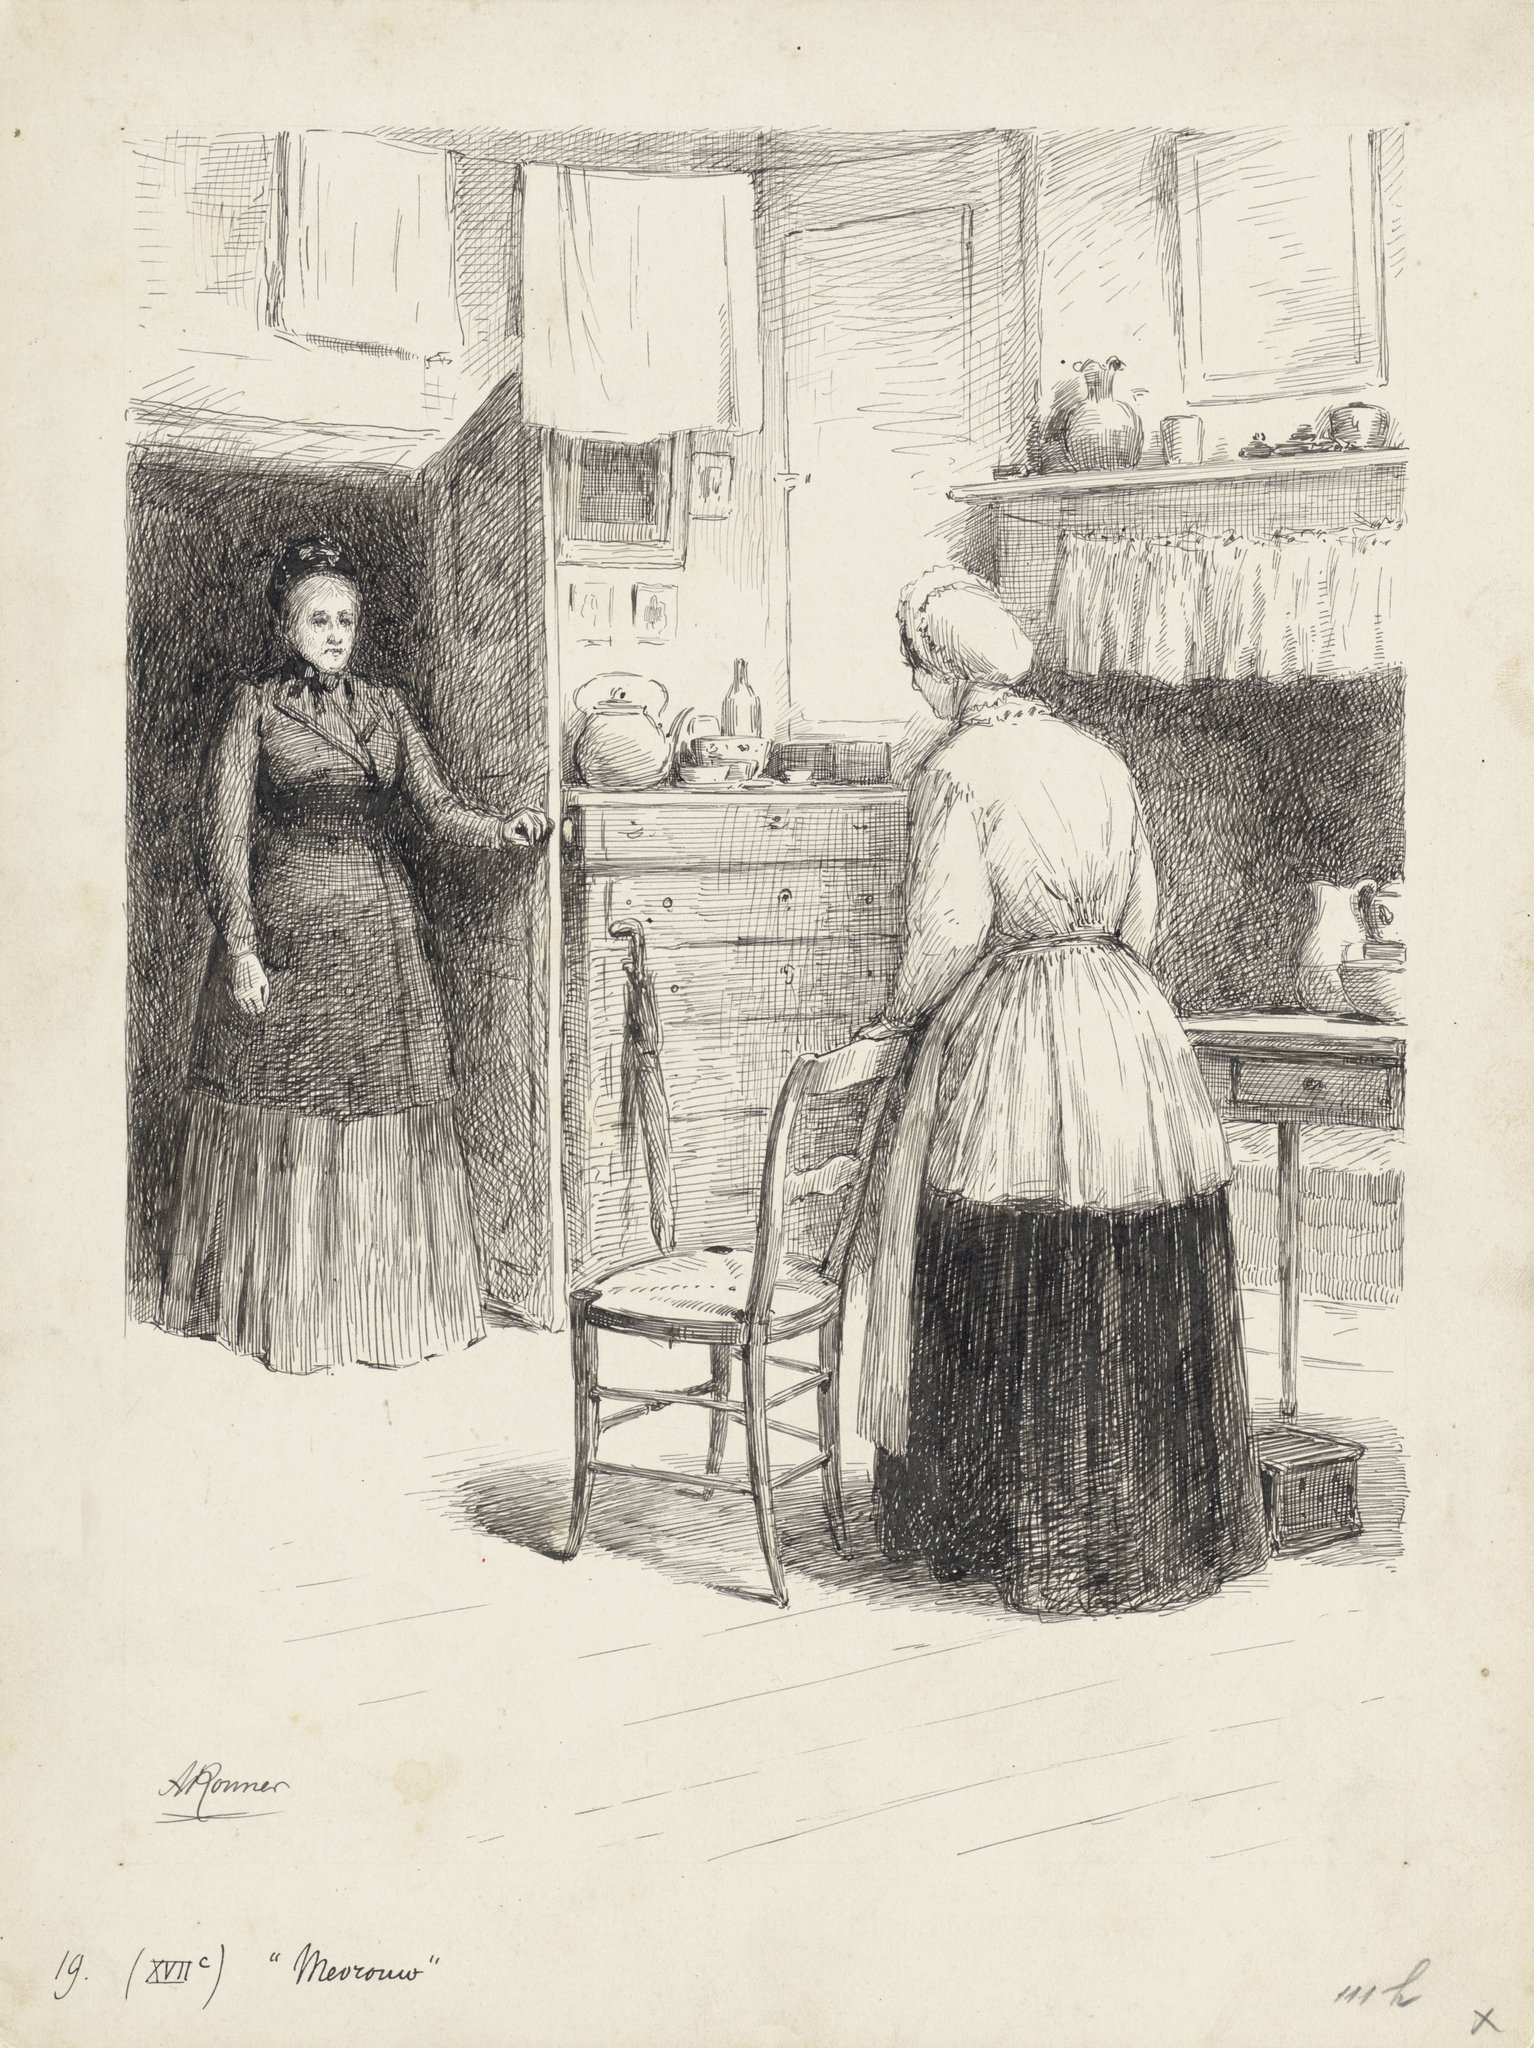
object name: design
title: Mevrouw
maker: alfred ronner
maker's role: draughtsman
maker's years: 1852-1901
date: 1893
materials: ink, paper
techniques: pen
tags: (reiger, a.f.j., vluchtige schetsen uit het volksleven) specific works of literature (with author, title), kitchen-maid, kitchen servant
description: Illustratie voor 'Vluchtige Schetsen uit het Volksleven' door A.F.J. Reiger. Ontwerp voor een prent.